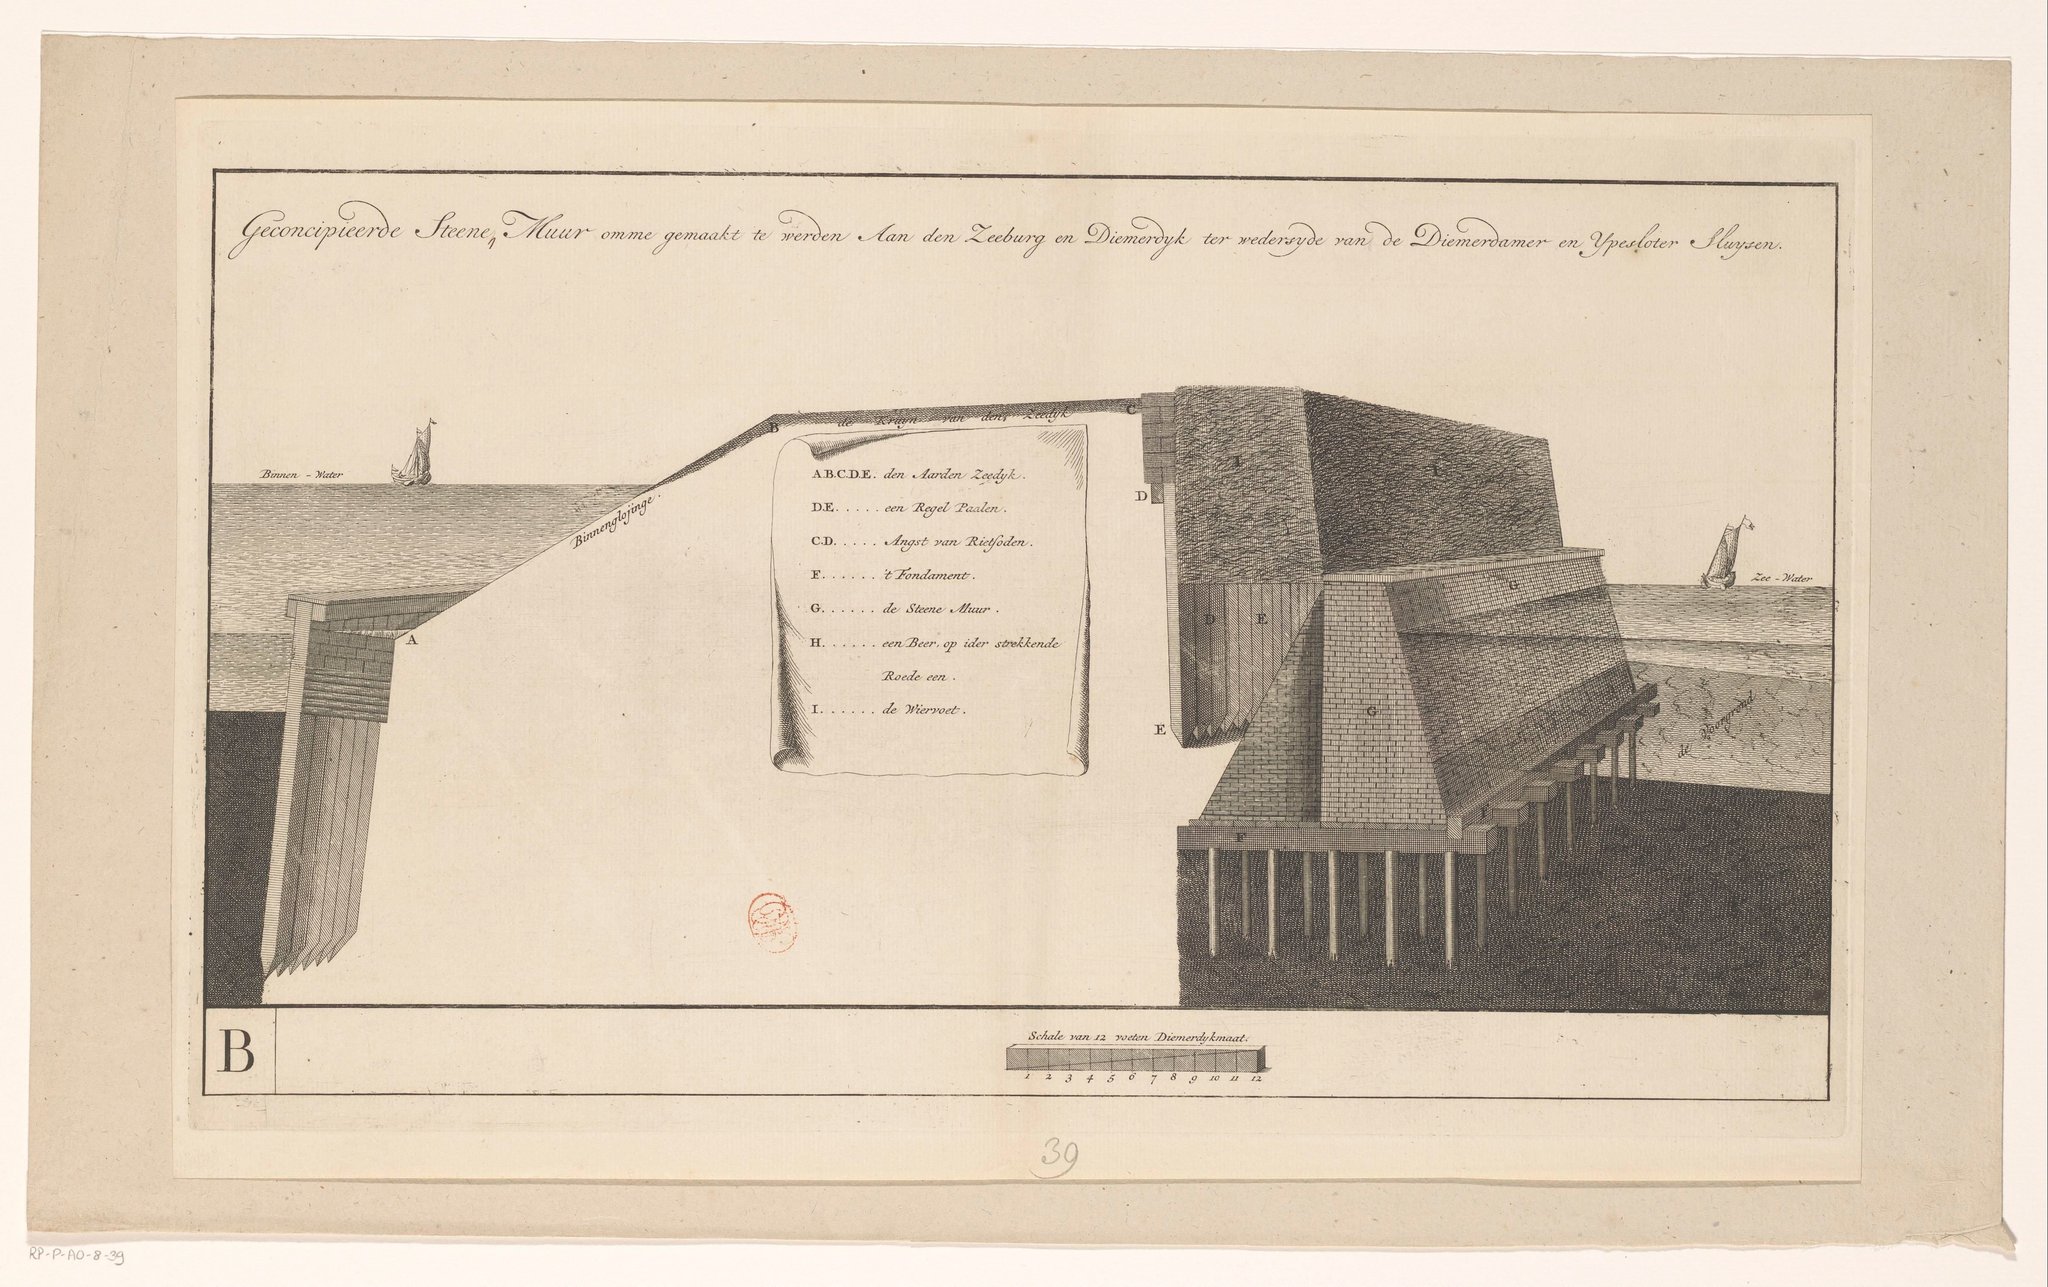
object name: print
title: Profiel van een ontwerp ter vernieuwing en versterking van de Diemerzeedijk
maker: coenraad de putter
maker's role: print maker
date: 1729-1737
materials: paper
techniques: engraving, etching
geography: amsterdam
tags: sailing-ship, sailing-boat, dikes, levee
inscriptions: collector's mark: Lugt 195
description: Rond 1730 waren de houten palen van de Diemerzeedijk ernstig aangetast door paalworm. In 1737 zouden de houten palen worden vervangen door stenen. Landmeter A.D. Mutsert maakte een aantal tekeningen van de toenmalige Diemerzeedijk en Diemerlanddijk en mogelijke verbeteringen, waarvan ook prenten zijn gemaakt. De huidige prent is daar een van. Zie ook RP-P-AO-8-38 en RP-P-AO-8-40.